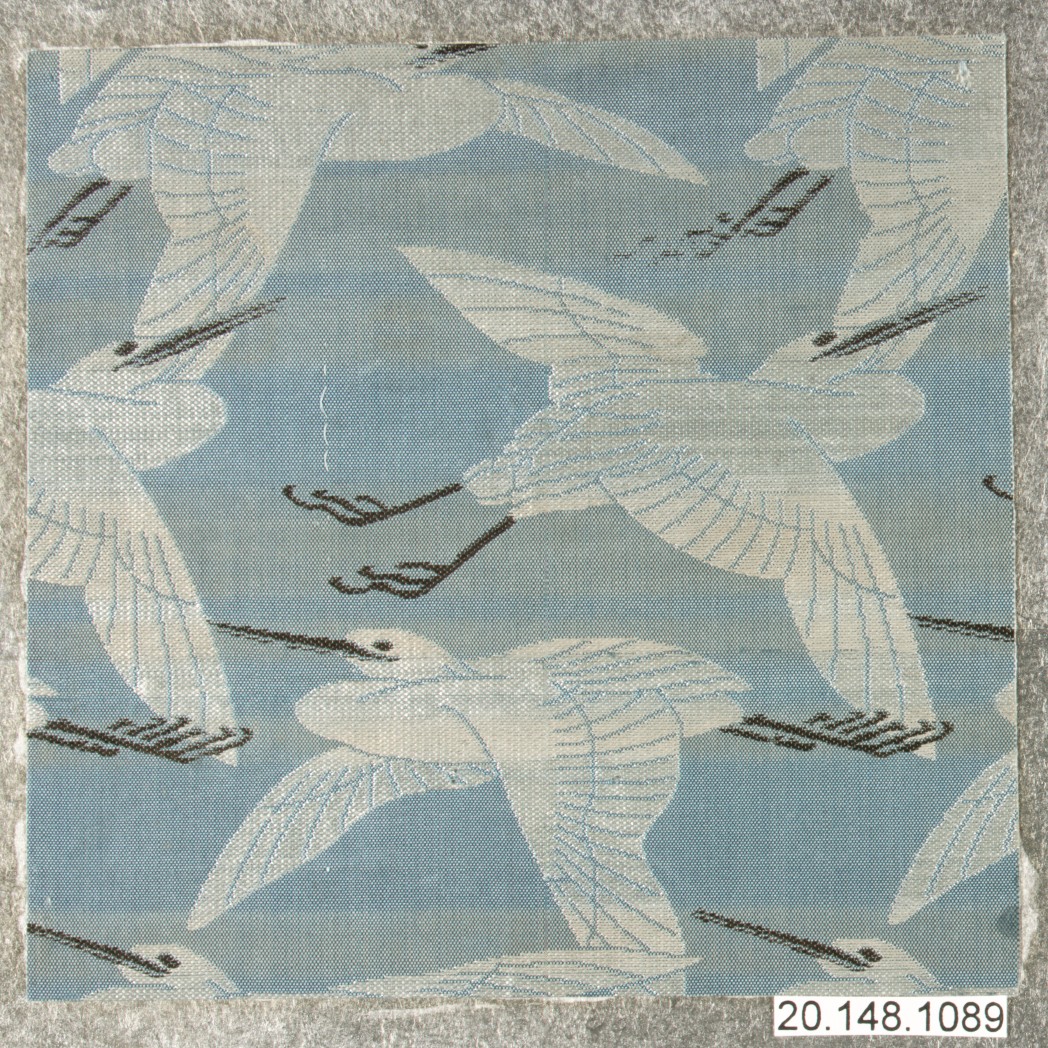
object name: piece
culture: japanese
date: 1801-1900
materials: silk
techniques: compound weave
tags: birds